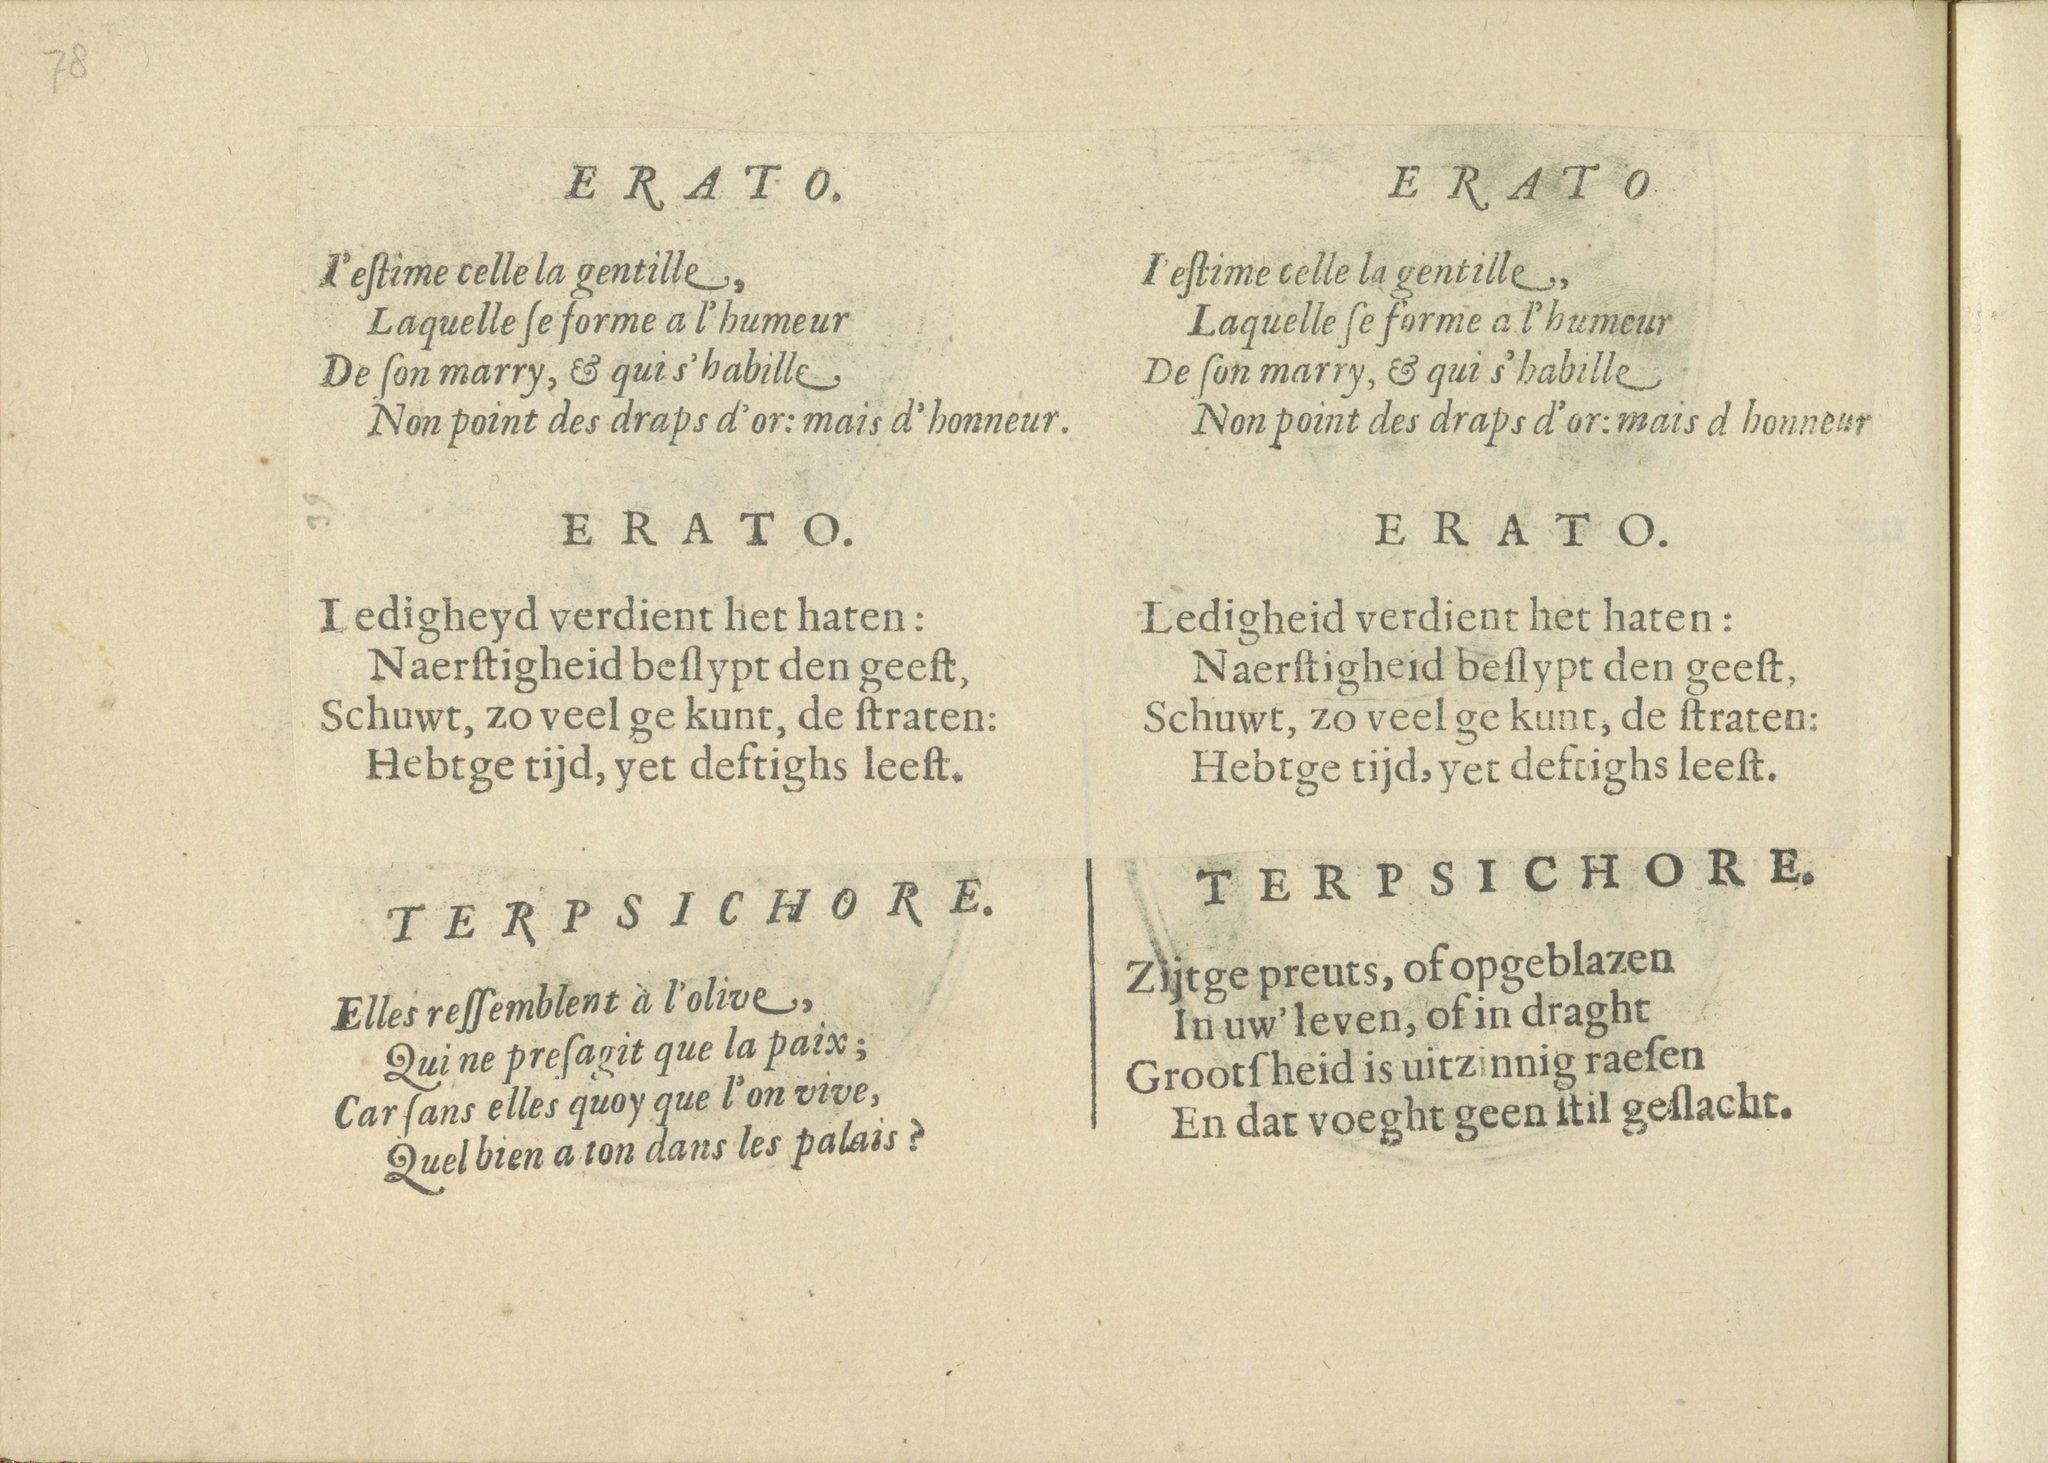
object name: text sheet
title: Kwatrijnen bij de voorstellingen van de muzen Erato en Terpsichore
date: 1640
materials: paper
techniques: letterpress printing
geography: amsterdam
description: Twee keer twee kwatrijnen in het Frans en Nederlands bij de voorstellingen van de muzen Erato en Terpsichore. De tekst bij Erato is op een losse strook toegevoegd. Daaronder de kwatrijnen bij de voorstellingen van Euterpe en Terpsichore. Het blad maakt deel uit van een album.